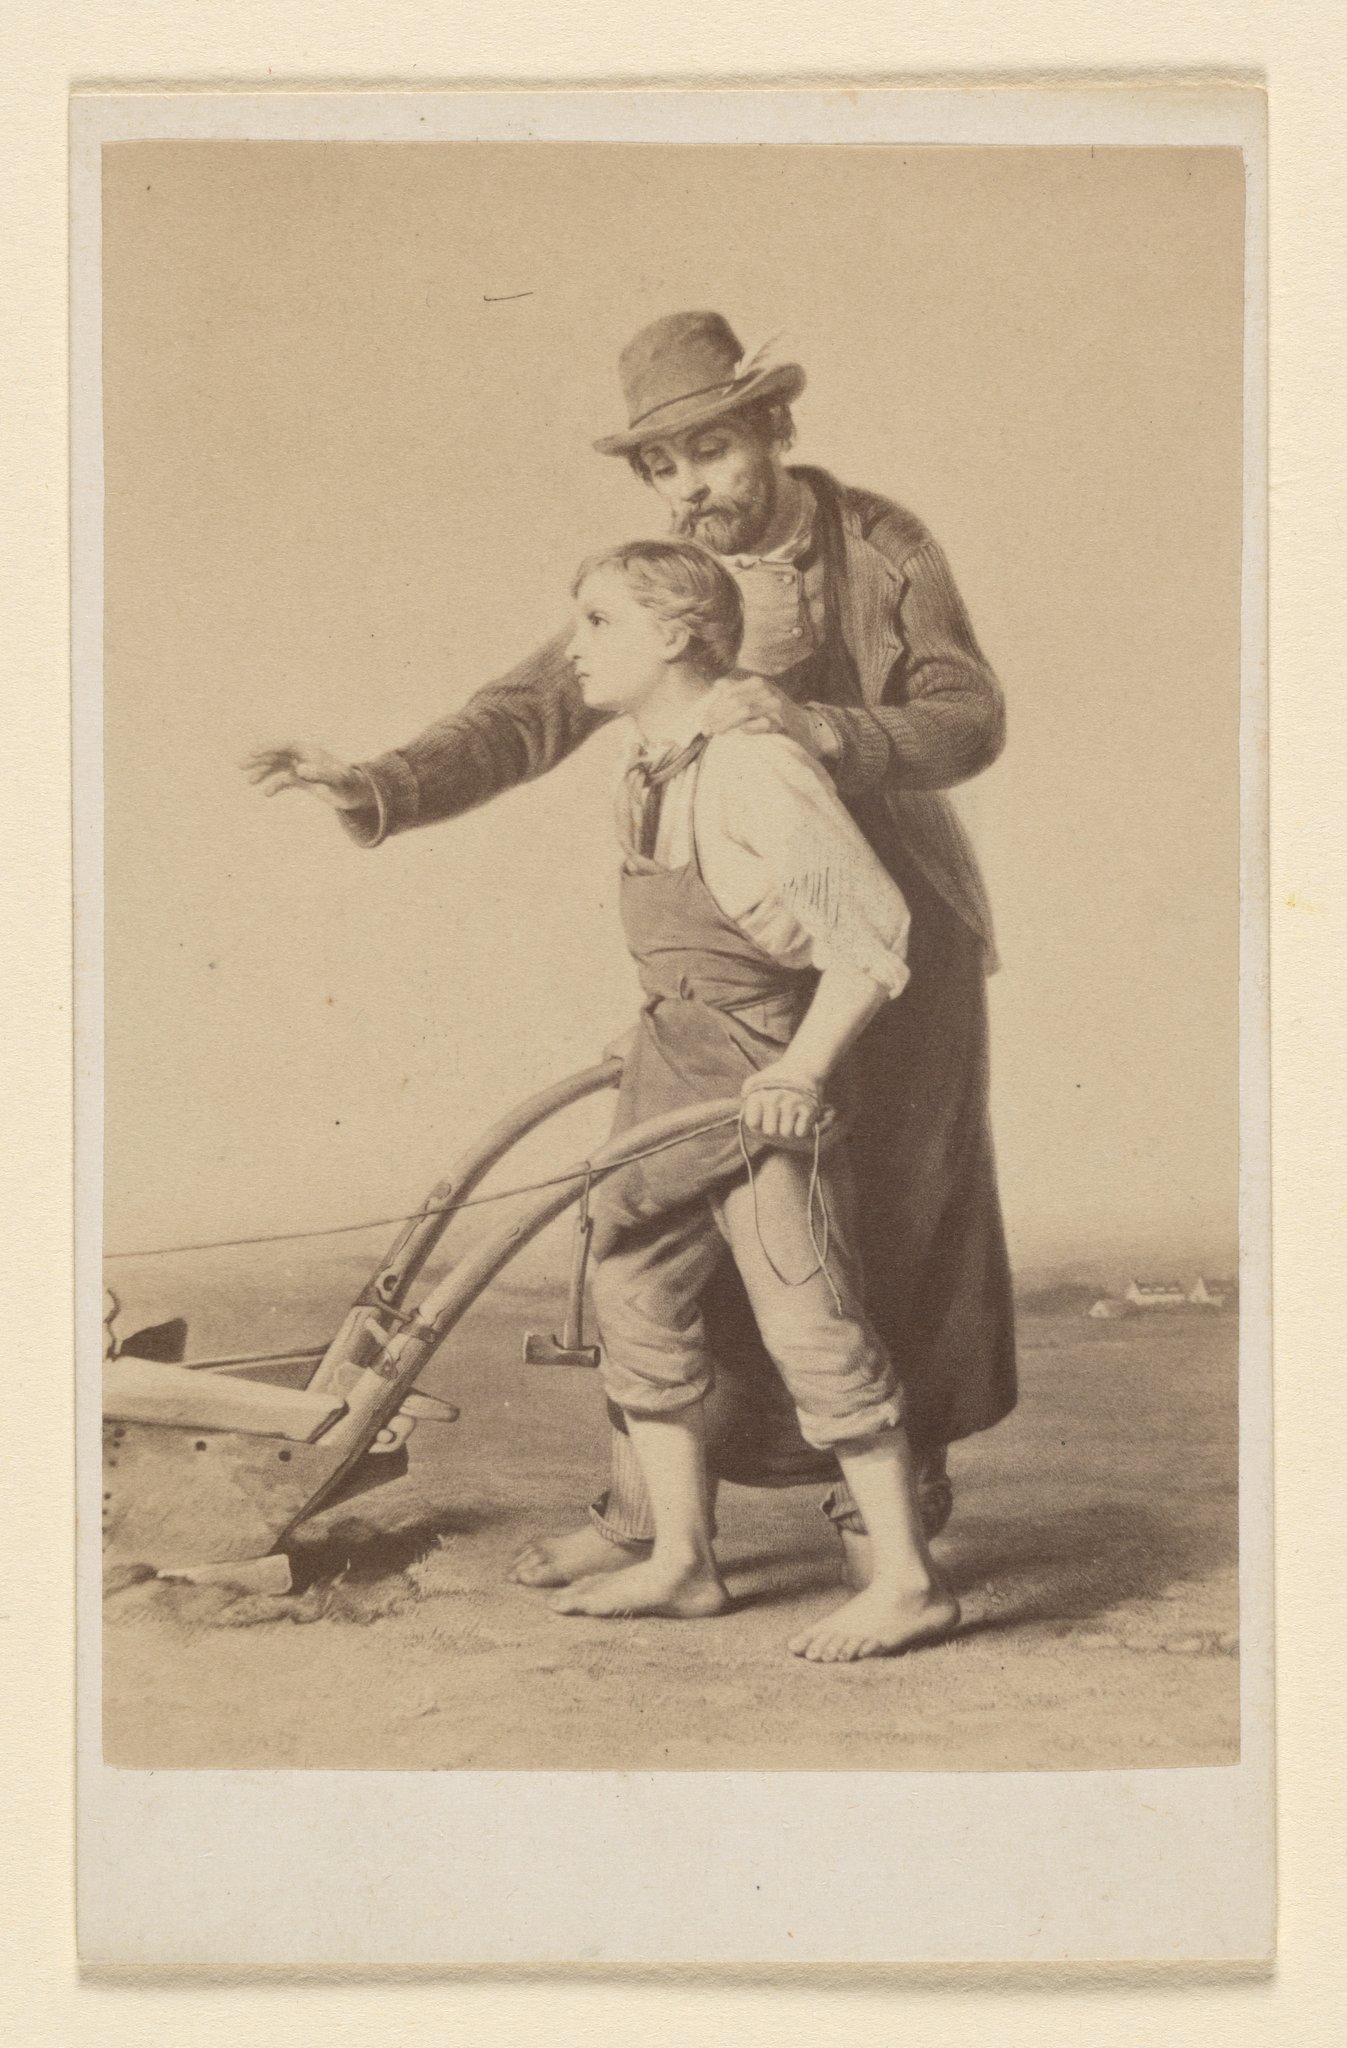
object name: carte de visite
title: [Edward Everett Hale and Son]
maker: Anonymous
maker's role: artist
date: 1865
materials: glass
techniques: albumen silver print